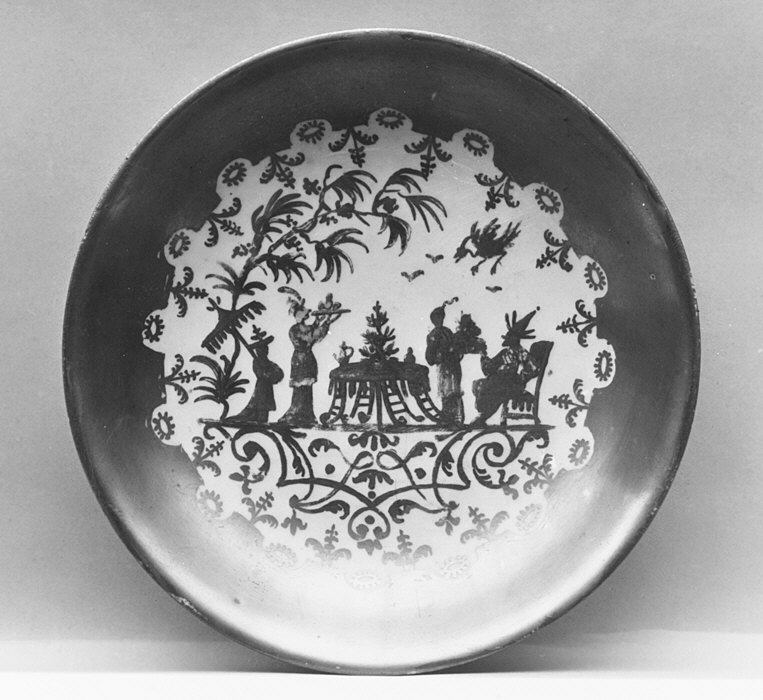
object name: saucer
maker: meissen manufactory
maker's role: manufactory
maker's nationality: german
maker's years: 1710-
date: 1701-1800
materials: porcelain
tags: human figures,trees